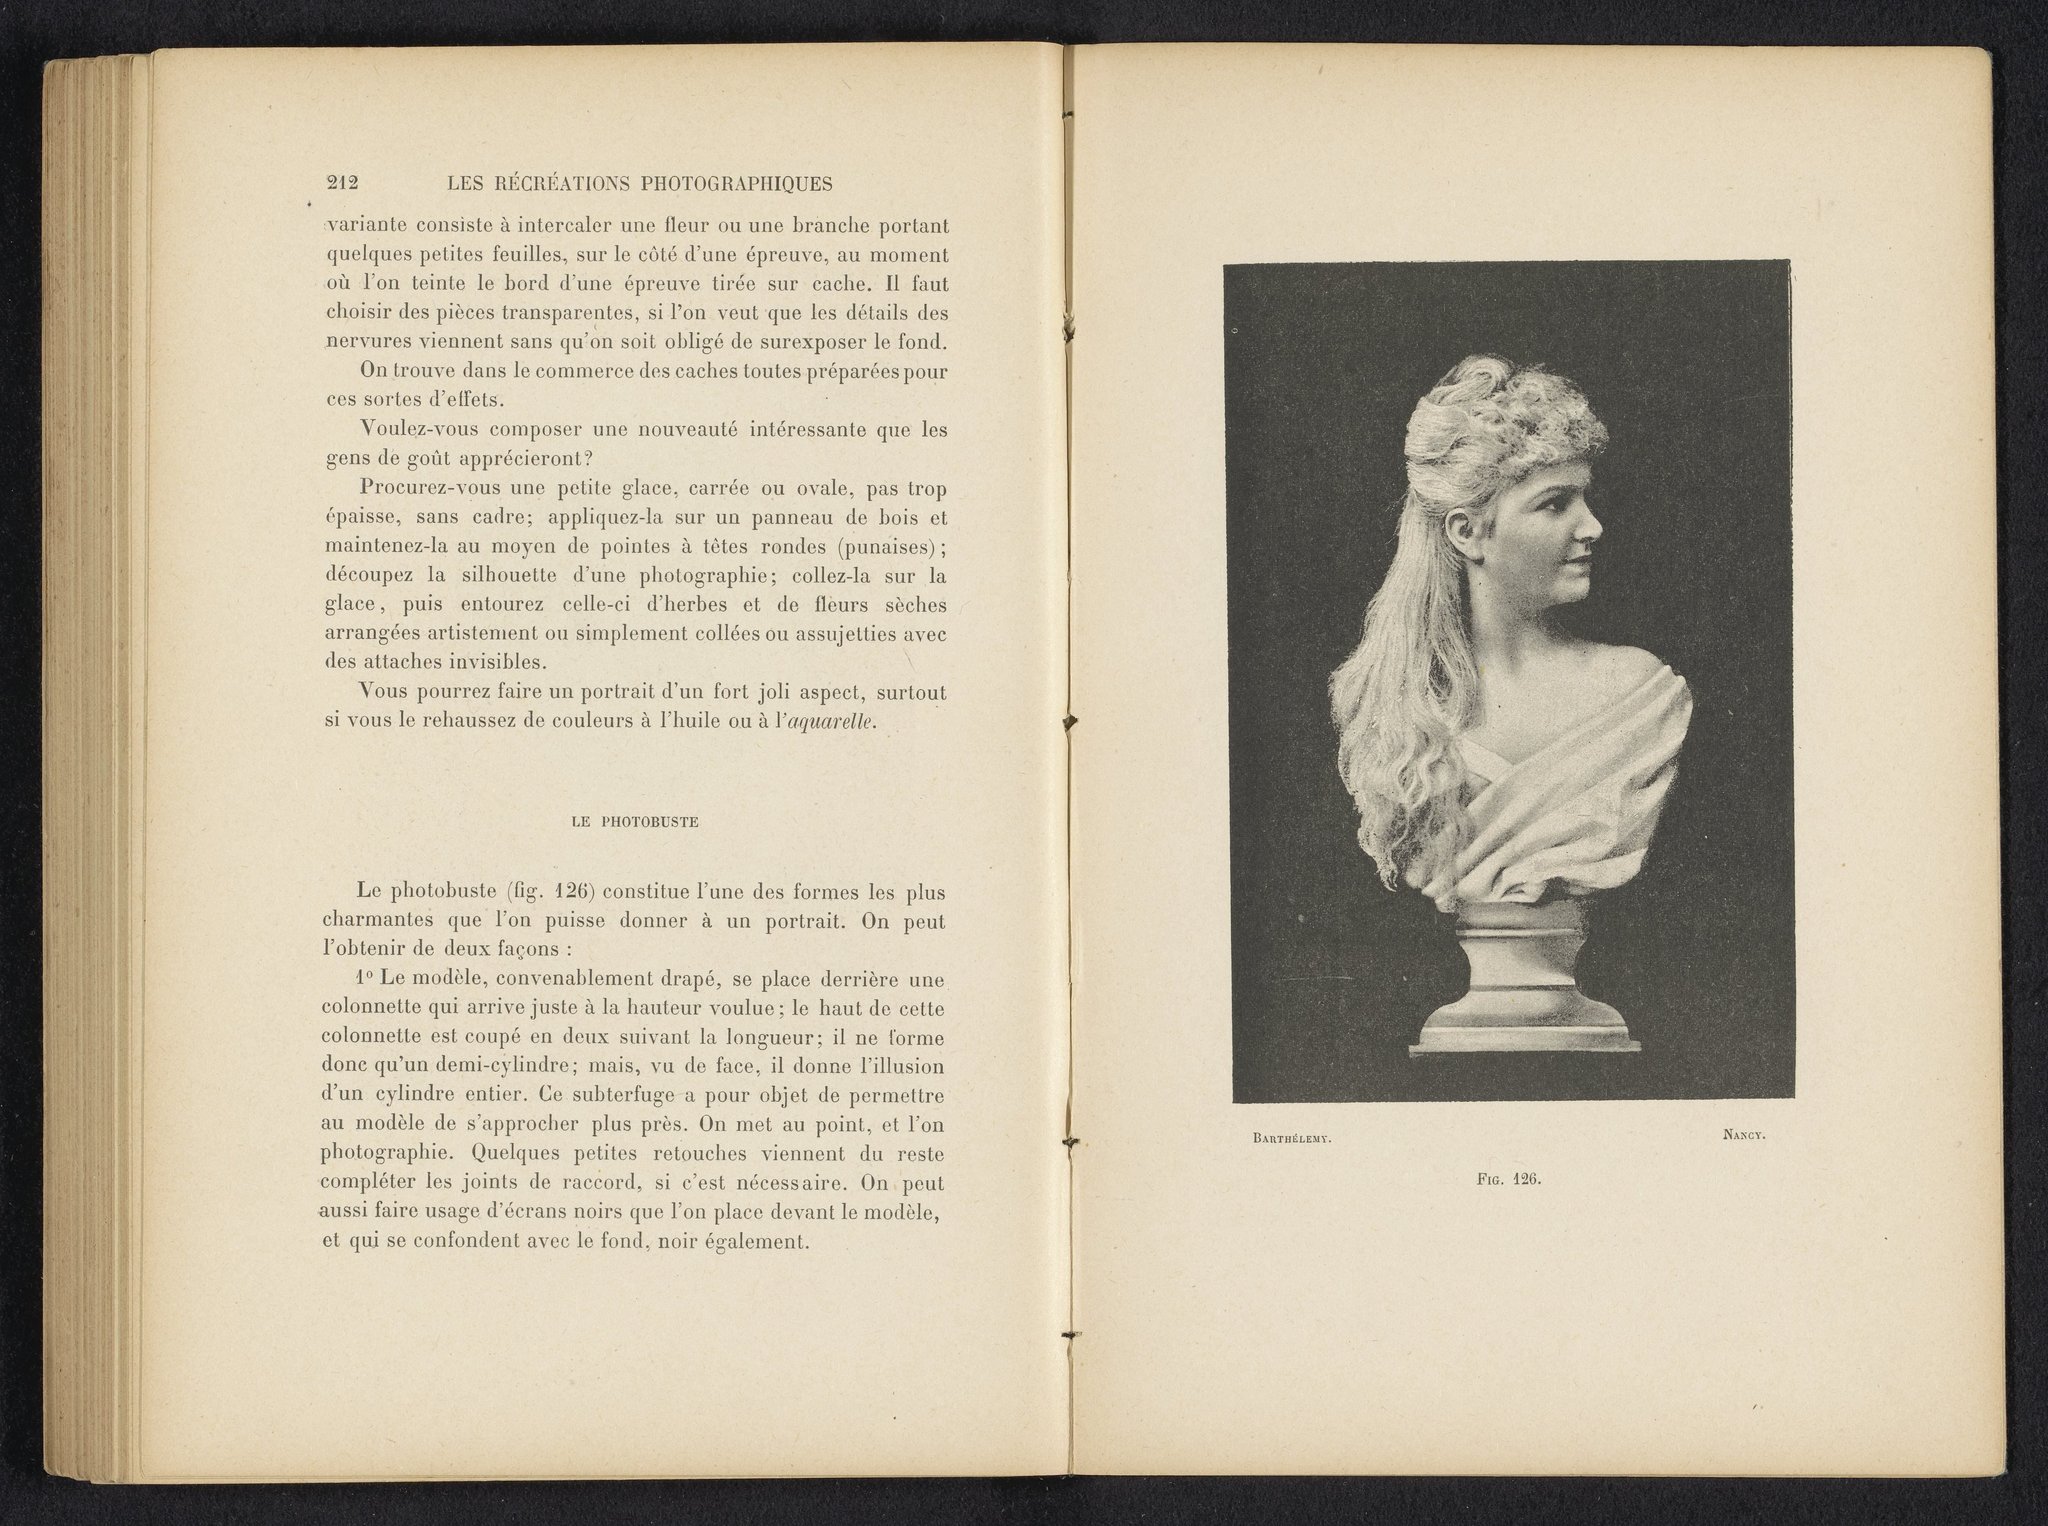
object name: photomechanical print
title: Portret van een onbekende vrouw op een sokkel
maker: Anonymous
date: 1883-1893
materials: paper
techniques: autotype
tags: chest, bust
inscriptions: number: ‘Fig. 126.’, name: ‘Barthélemy.’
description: Prent is opgenomen onder het kopje: Le Photobuste.